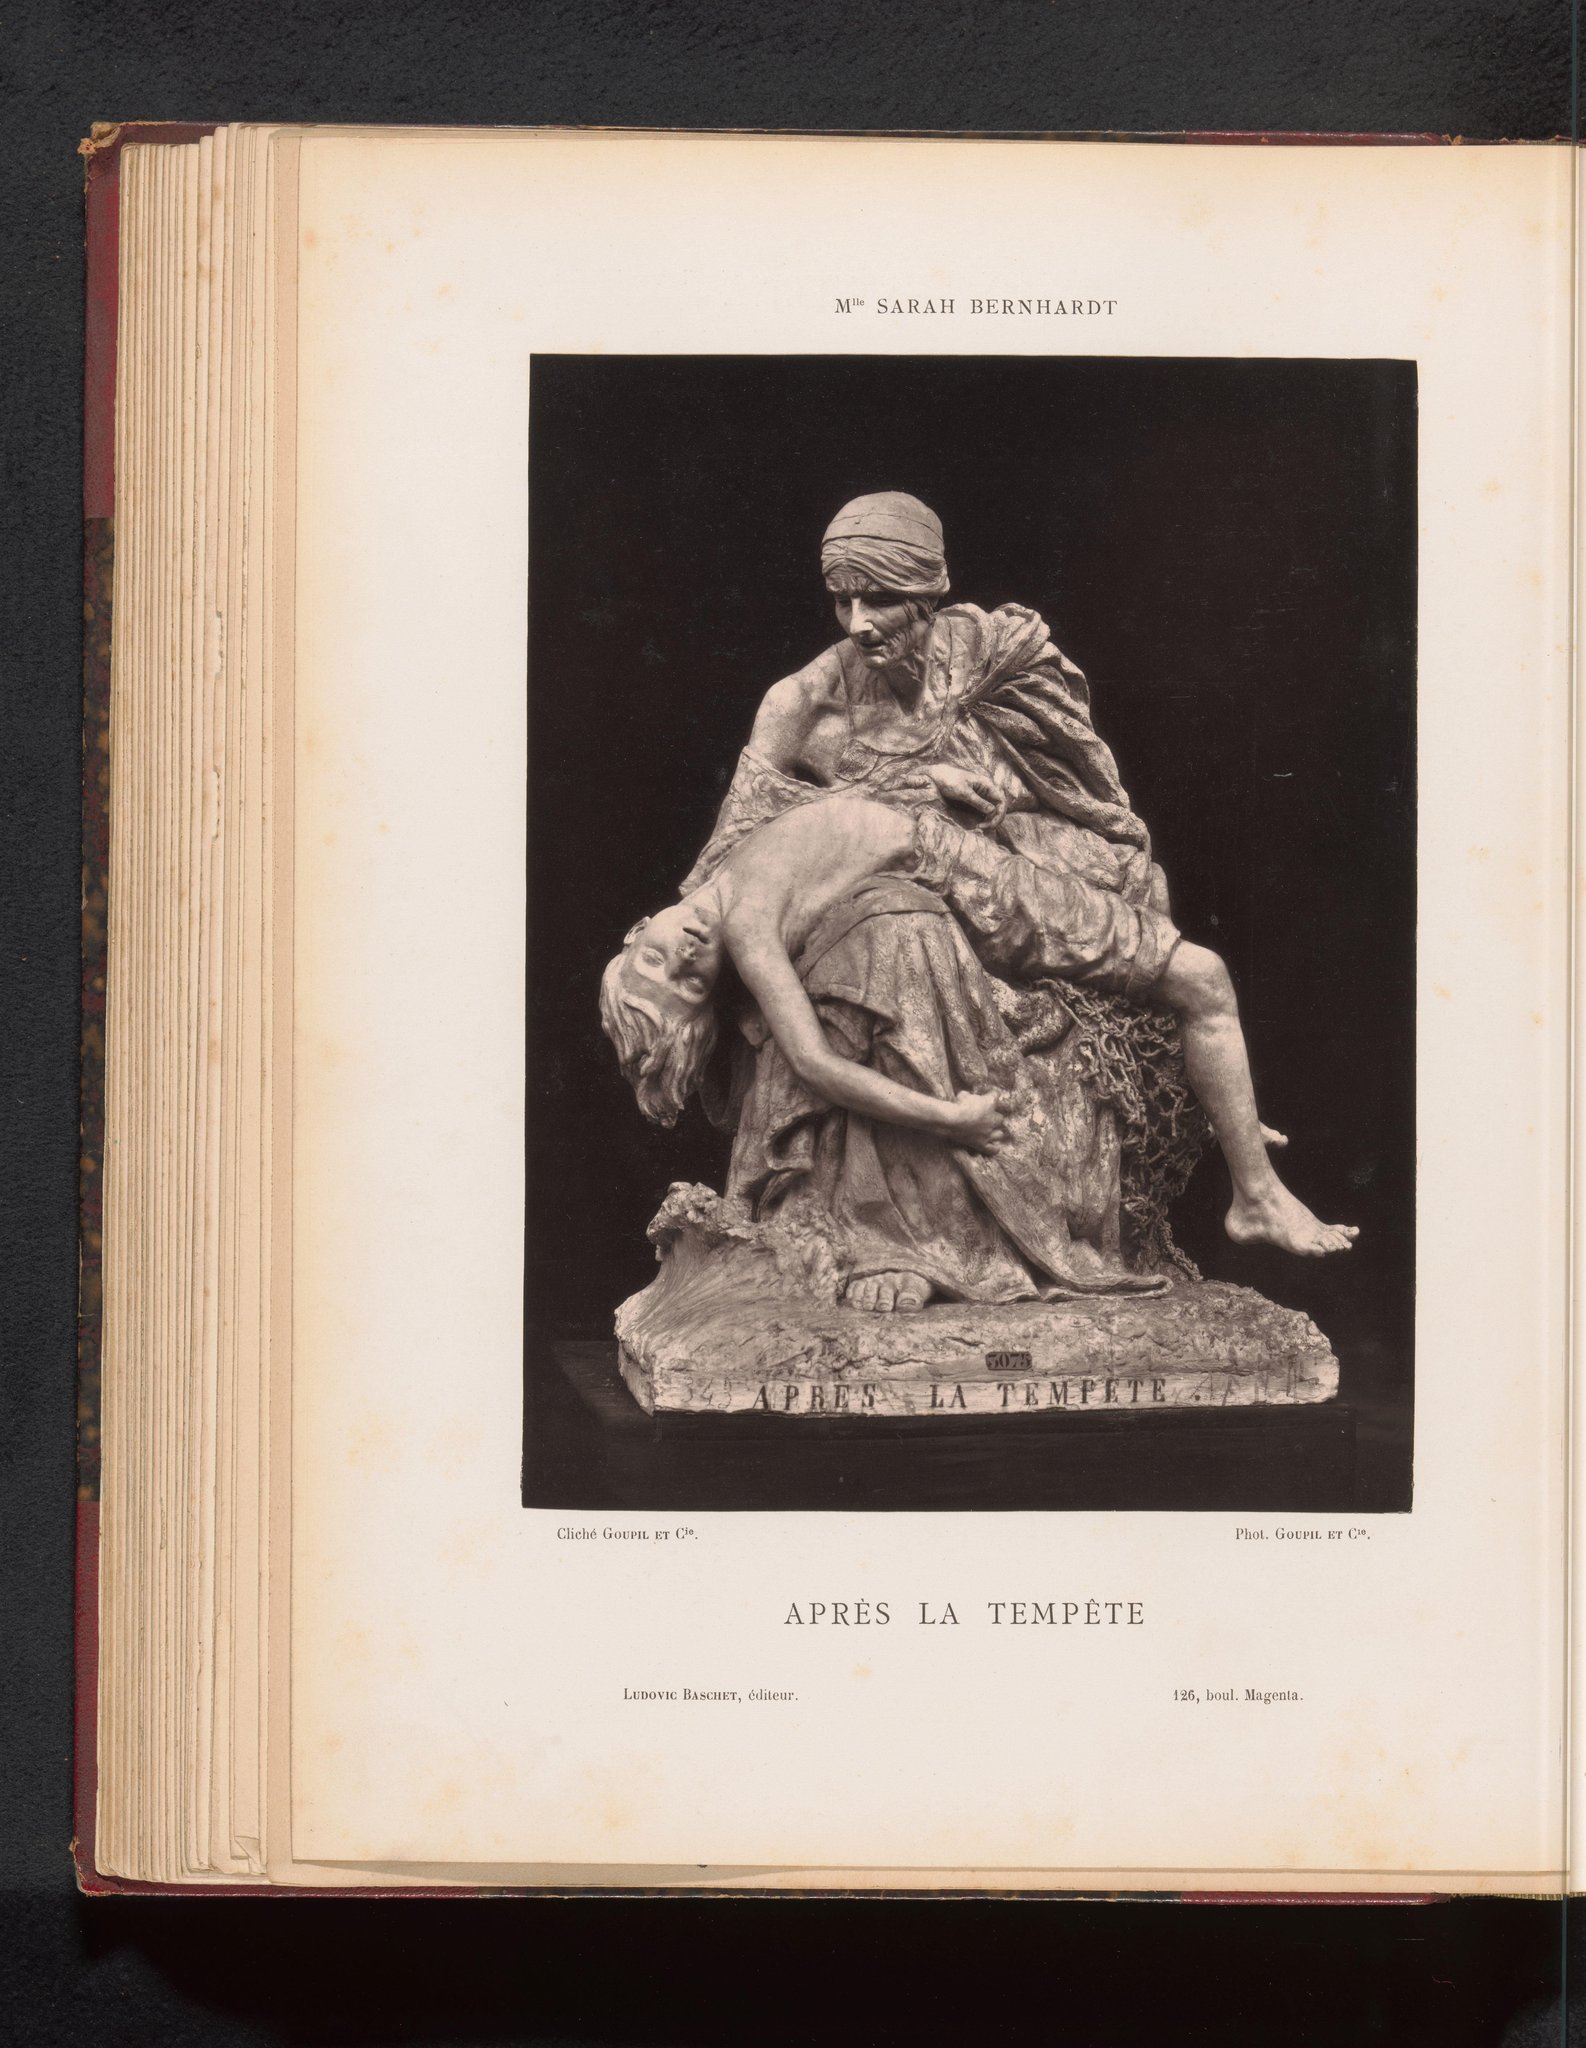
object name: page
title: Après la tempête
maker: charles marville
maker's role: print maker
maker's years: 1816-1879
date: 1871-1876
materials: paper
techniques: woodburytype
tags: grandparent(s) with grandchild(ren) (family group), sculpture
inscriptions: inscription: ‘Mlle Sarah Bernhardt/ Ludovic Baschet, éditeur. / 126, boul. Magenta’